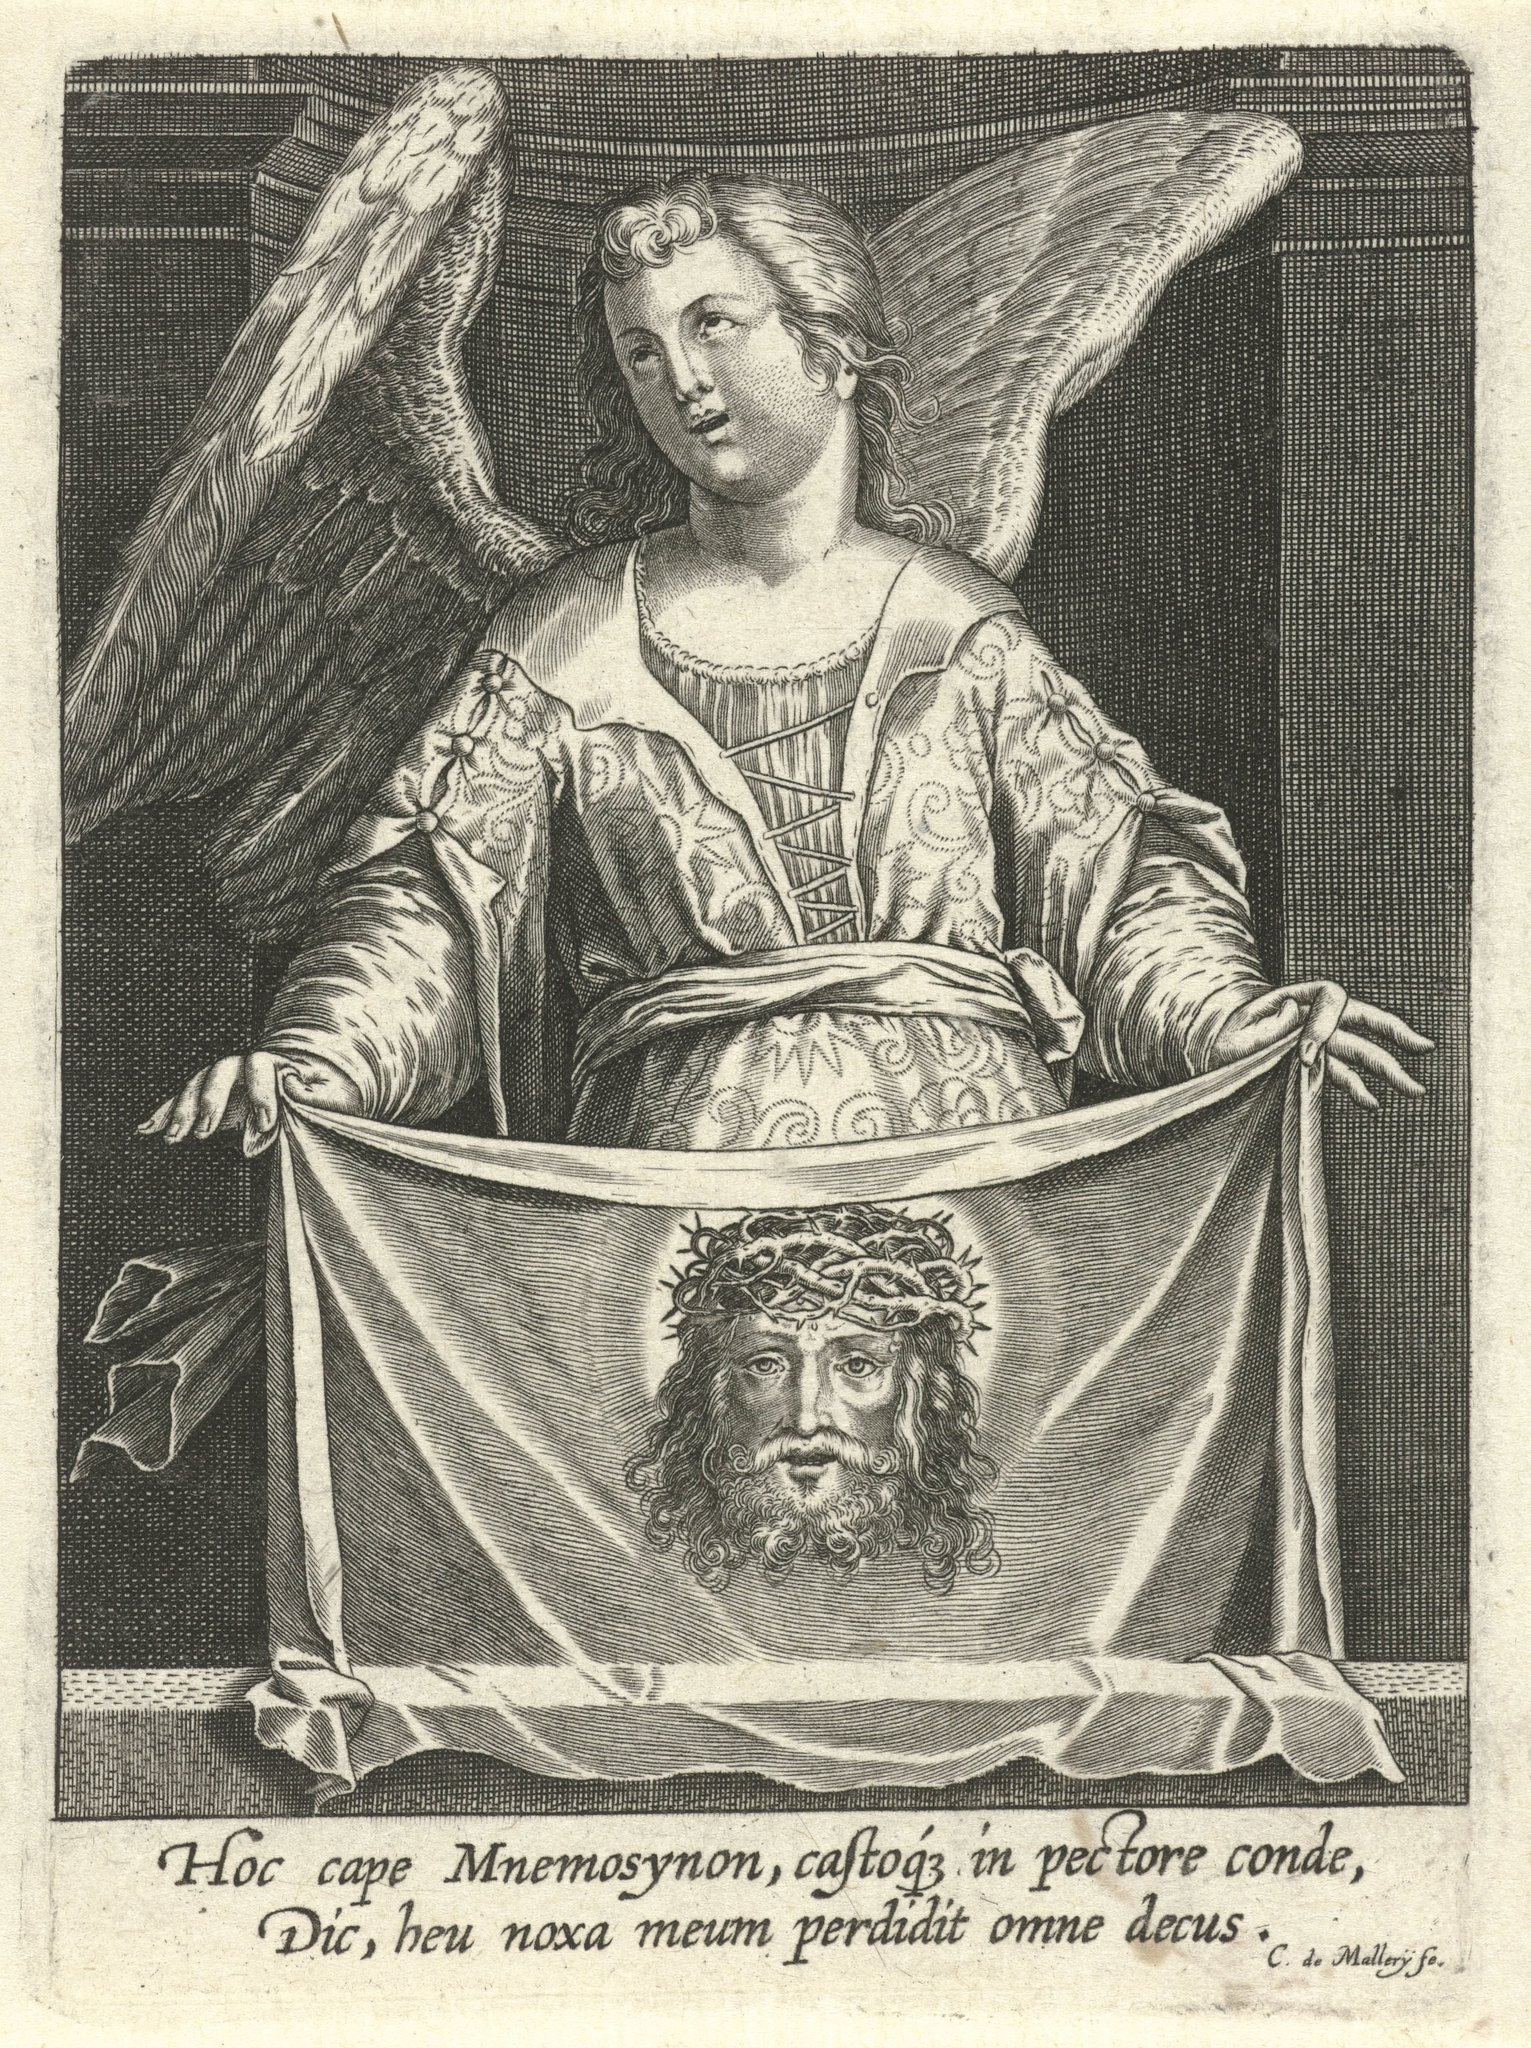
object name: print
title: Christus en zeven engelen met de Passiewerktuigen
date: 1581-1645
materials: paper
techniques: engraving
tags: virtues (holding instruments of the passion) ~ hierarchy of angels, 'vera icon', held up by angels, the instruments of the passion and the five wounded limbs, single instruments of the passion (with name)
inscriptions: collector's mark: Lugt 240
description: Engel met sudarium, of de veronicadoek; de zweetdoek waarmee Veronica Christus' gezicht afveegde toen Hij zijn kruis naar Golgotha droeg. Onder de voorstelling twee regels in het Latijn. Vijfde prent uit een serie van acht prenten met voorstellingen van engelen met de Passiewerktuigen.